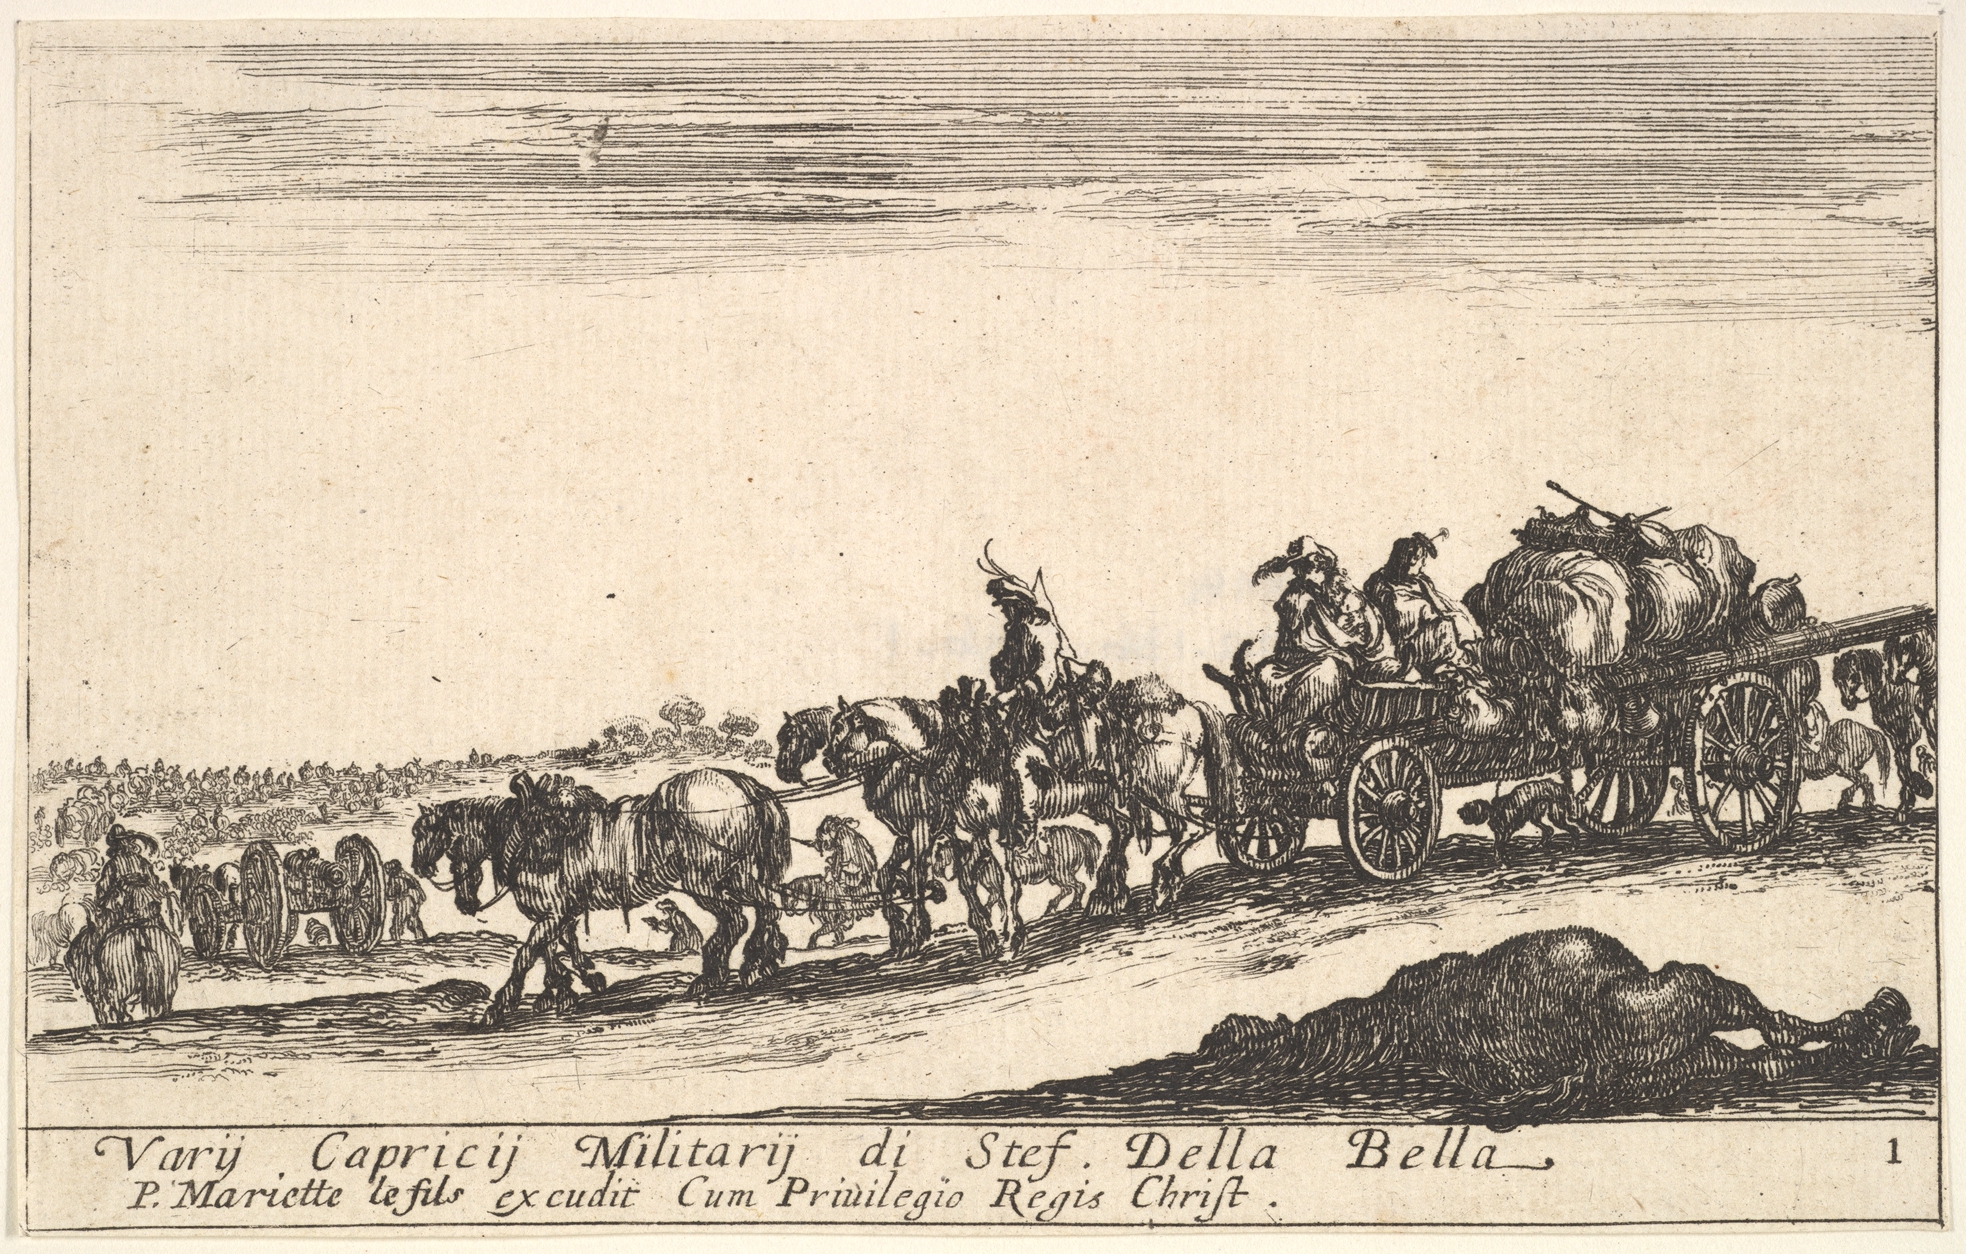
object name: print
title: Plate 1: A horse drawn cart carrying people and goods, dead horse in the foreground, from "Various Military Caprices" (Varii capricci militari)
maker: stefano della bella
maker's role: artist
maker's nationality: italian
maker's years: 1610-1664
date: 1641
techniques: etching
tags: human figures,horses,carriages